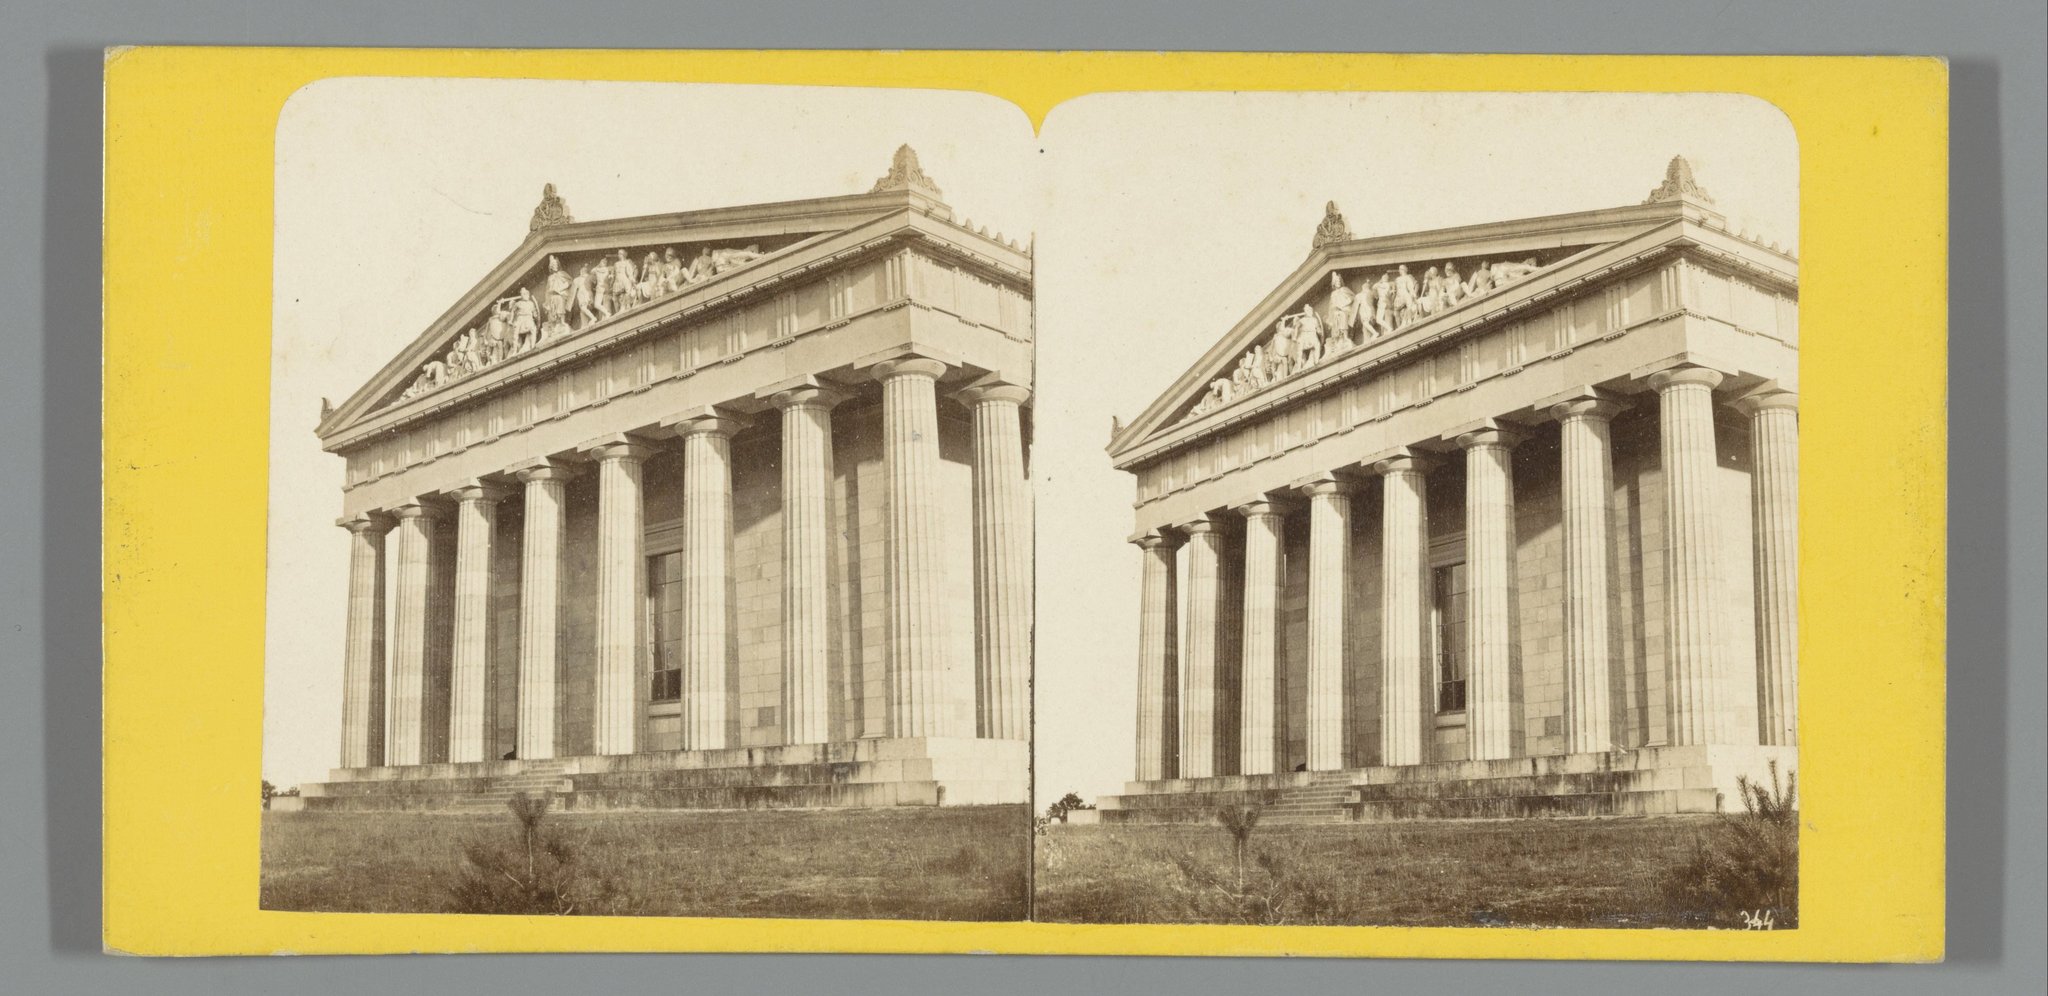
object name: stereograph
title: Bayern.-Donau. Nordseite der Walhalla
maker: monogrammist ac (fotograaf)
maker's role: fotograaf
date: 1850-1880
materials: cardboard, photographic support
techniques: albumen print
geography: donaustauf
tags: gallery of sculptures, façade (of house or building)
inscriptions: number: ‘No 344’